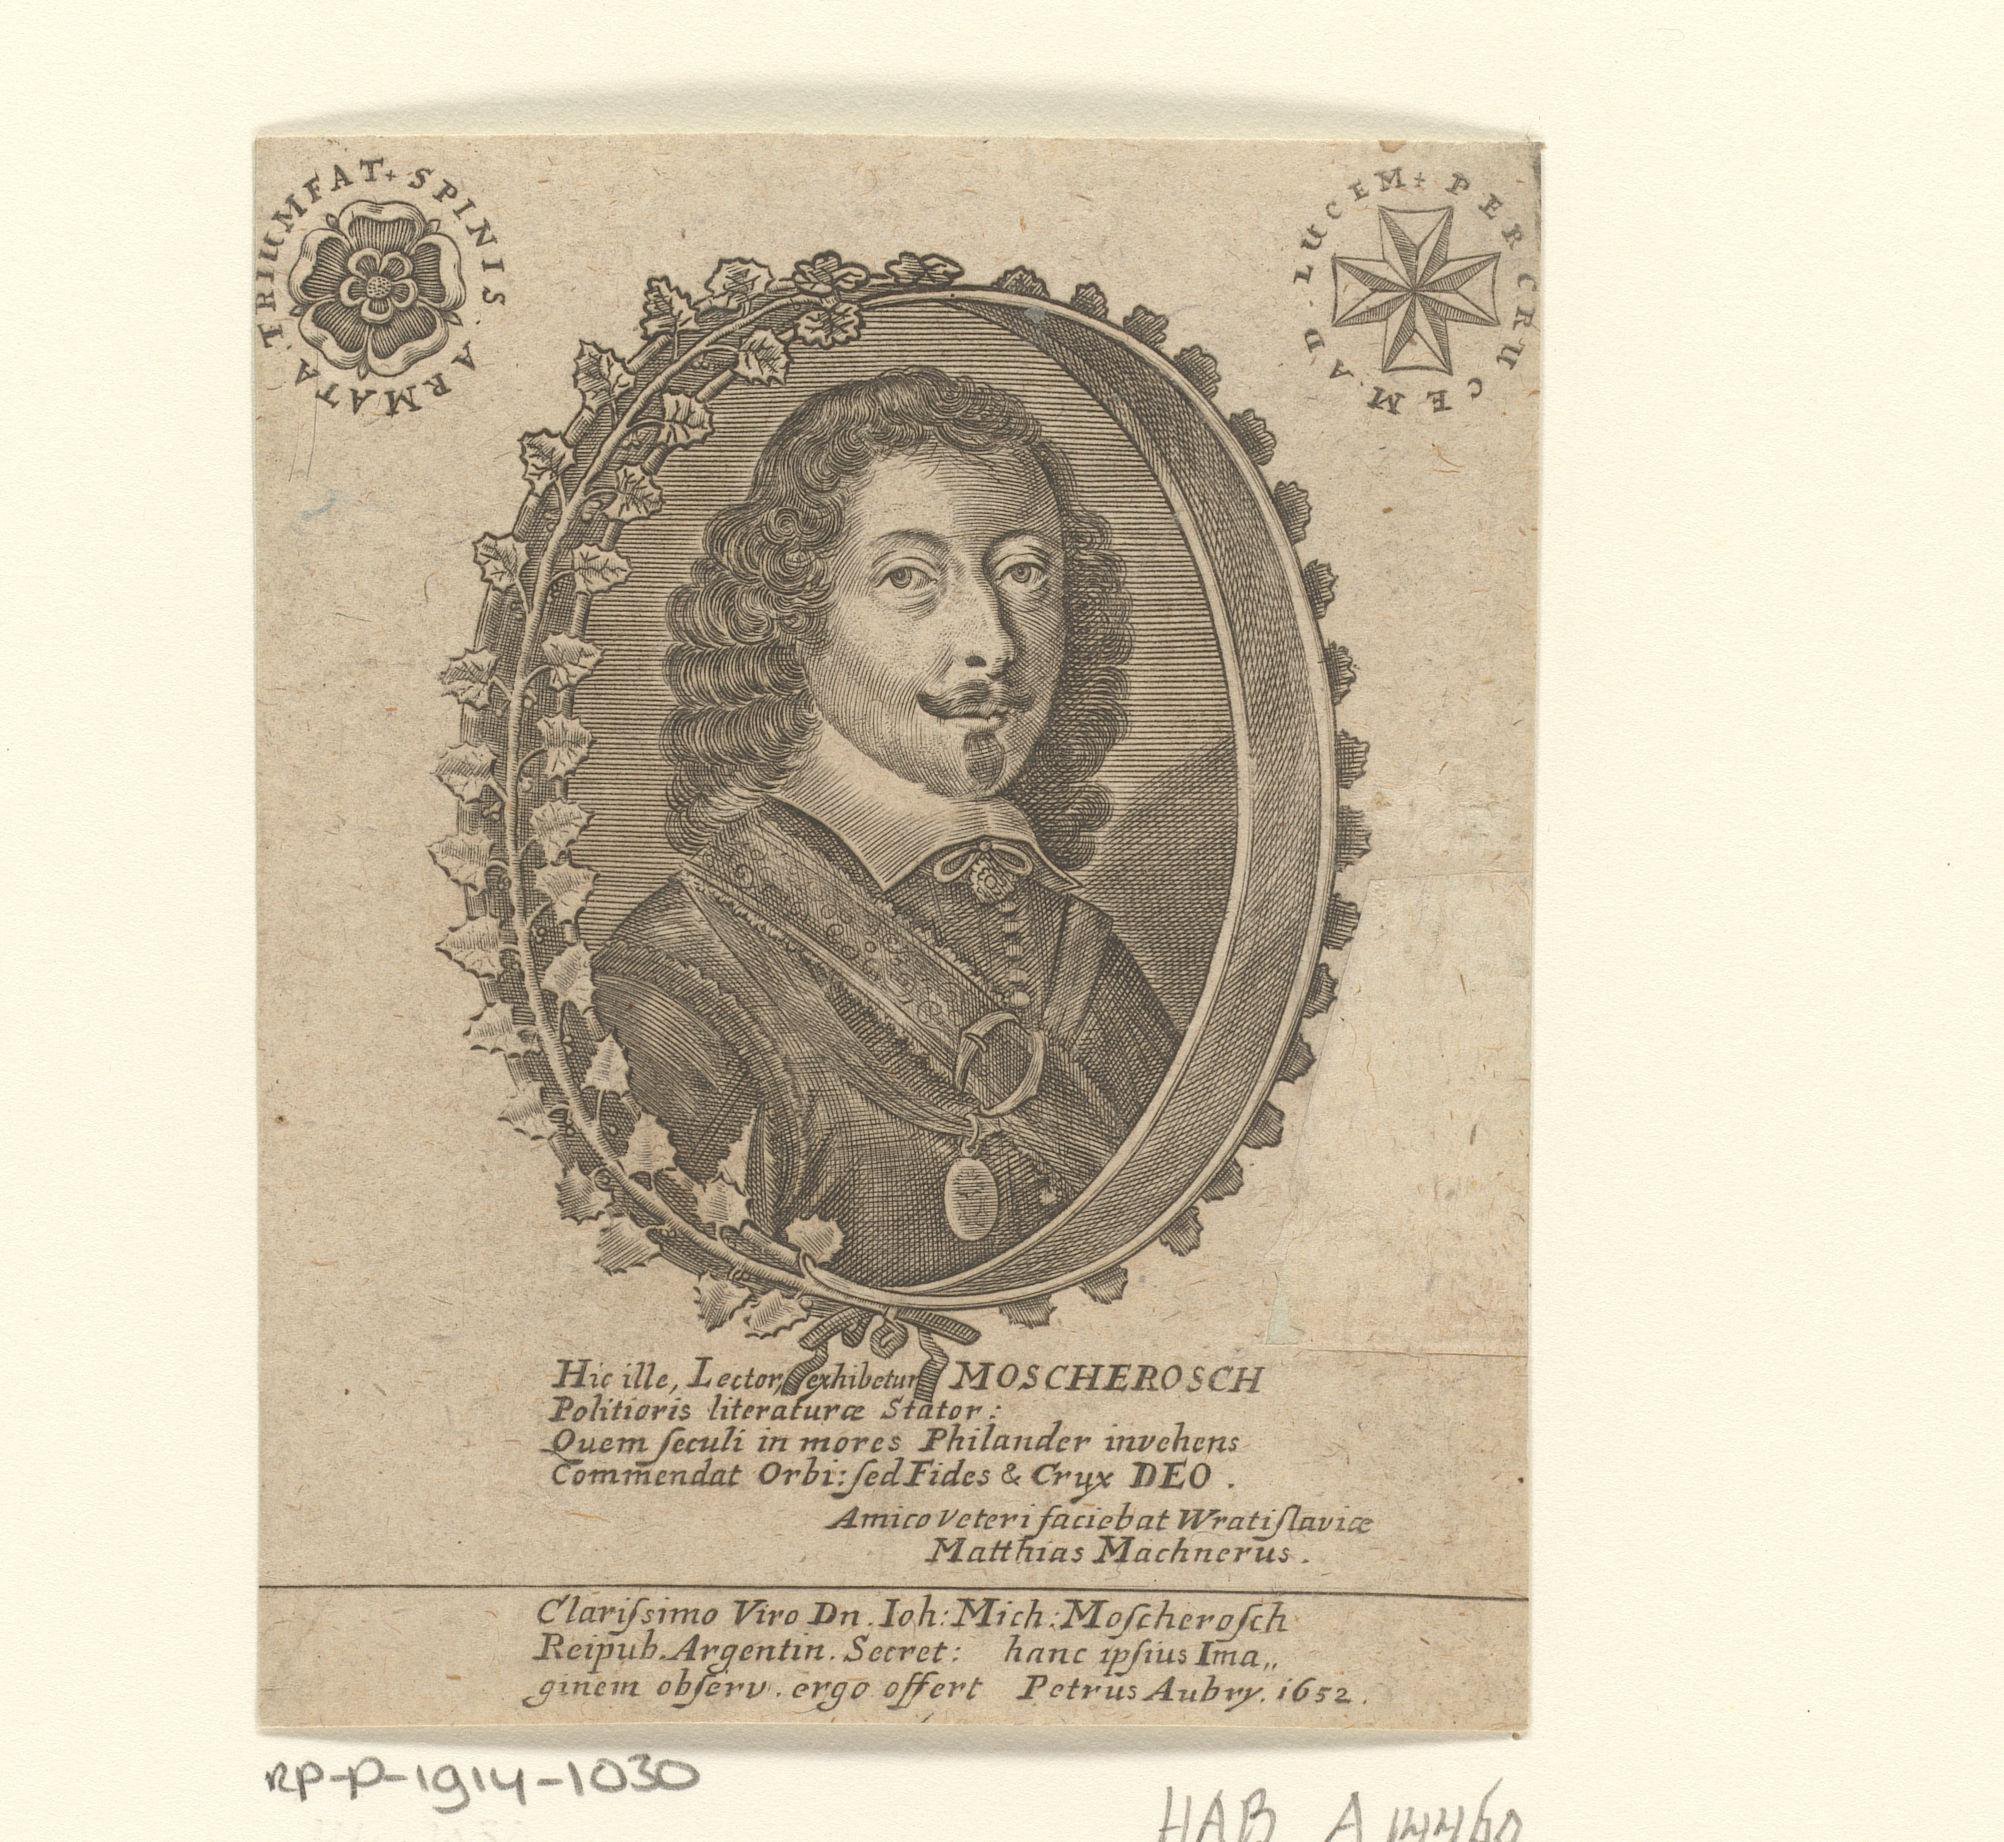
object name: print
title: Portret van Johann Michael Moscherosch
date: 1652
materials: paper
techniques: engraving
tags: johann michael moscherosch, historical persons, portrait of a writer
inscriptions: collector's mark: Lugt 2228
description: Met negenregelig onderschrift in het Latijn.